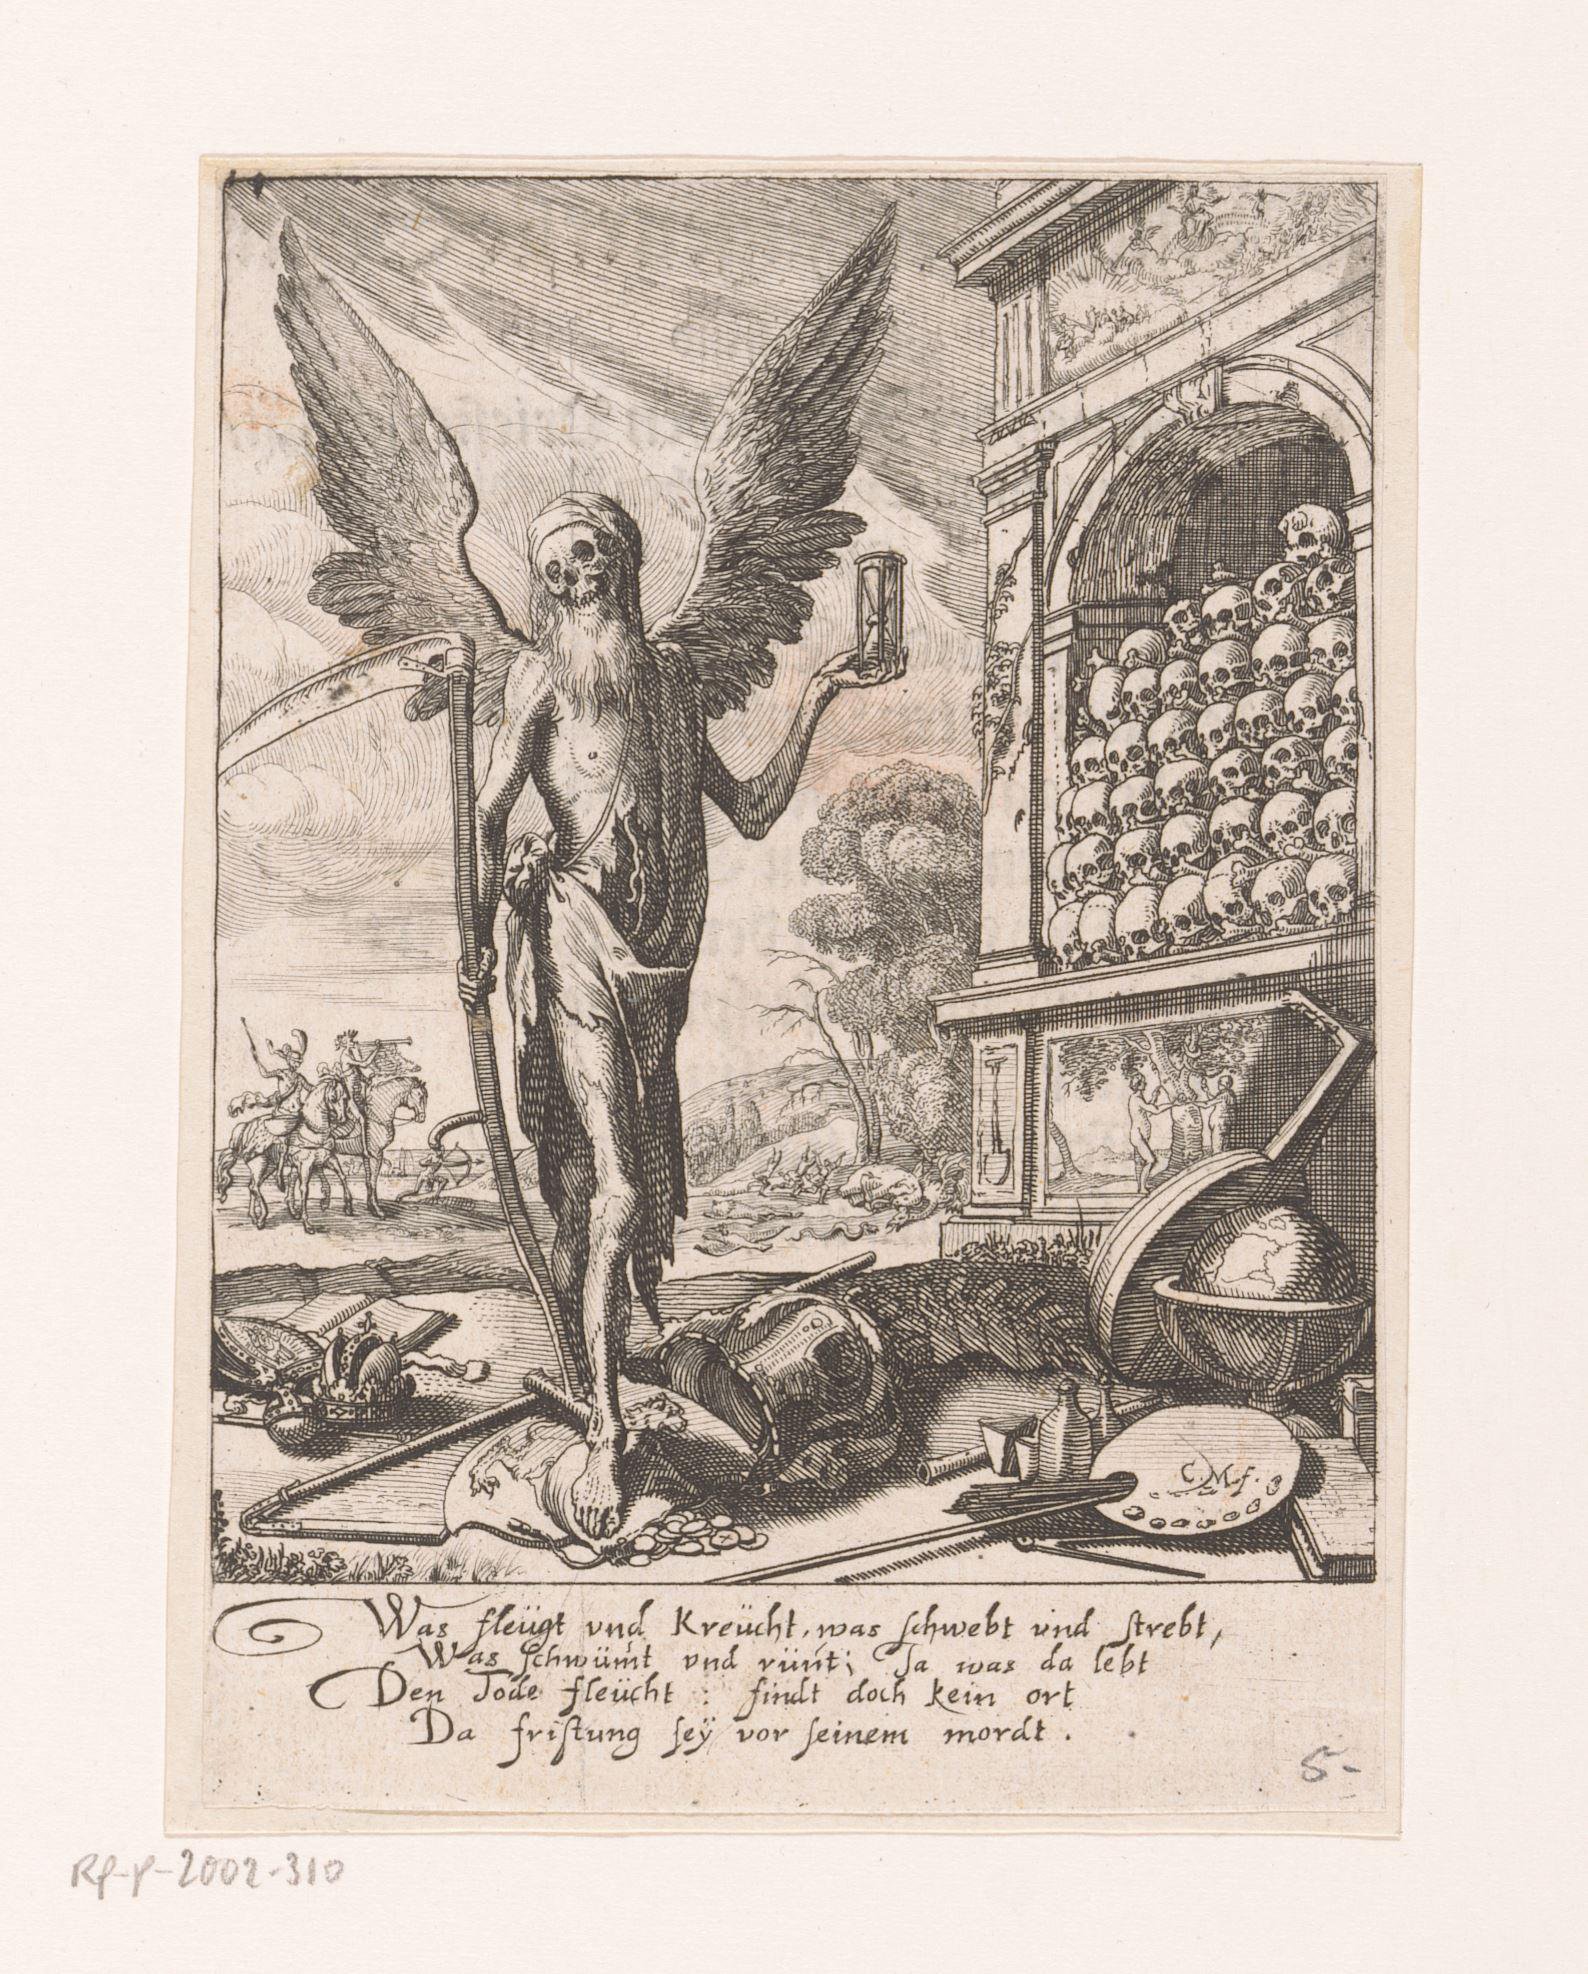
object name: print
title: Triomf van de Dood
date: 1650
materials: paper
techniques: etching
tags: adam and eve doing penance, personifications of death; 'morte' (ripa), dance of death; death together with one or more human beings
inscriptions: collector's mark: Lugt 2233, collector's mark: Lugt 2228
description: De Dood in de gedaante van een gevleugeld skelet met baard, zeis en zandloper in de hand, staand naast een nis vol met doodshoofden. Op de grond attributen van professies.